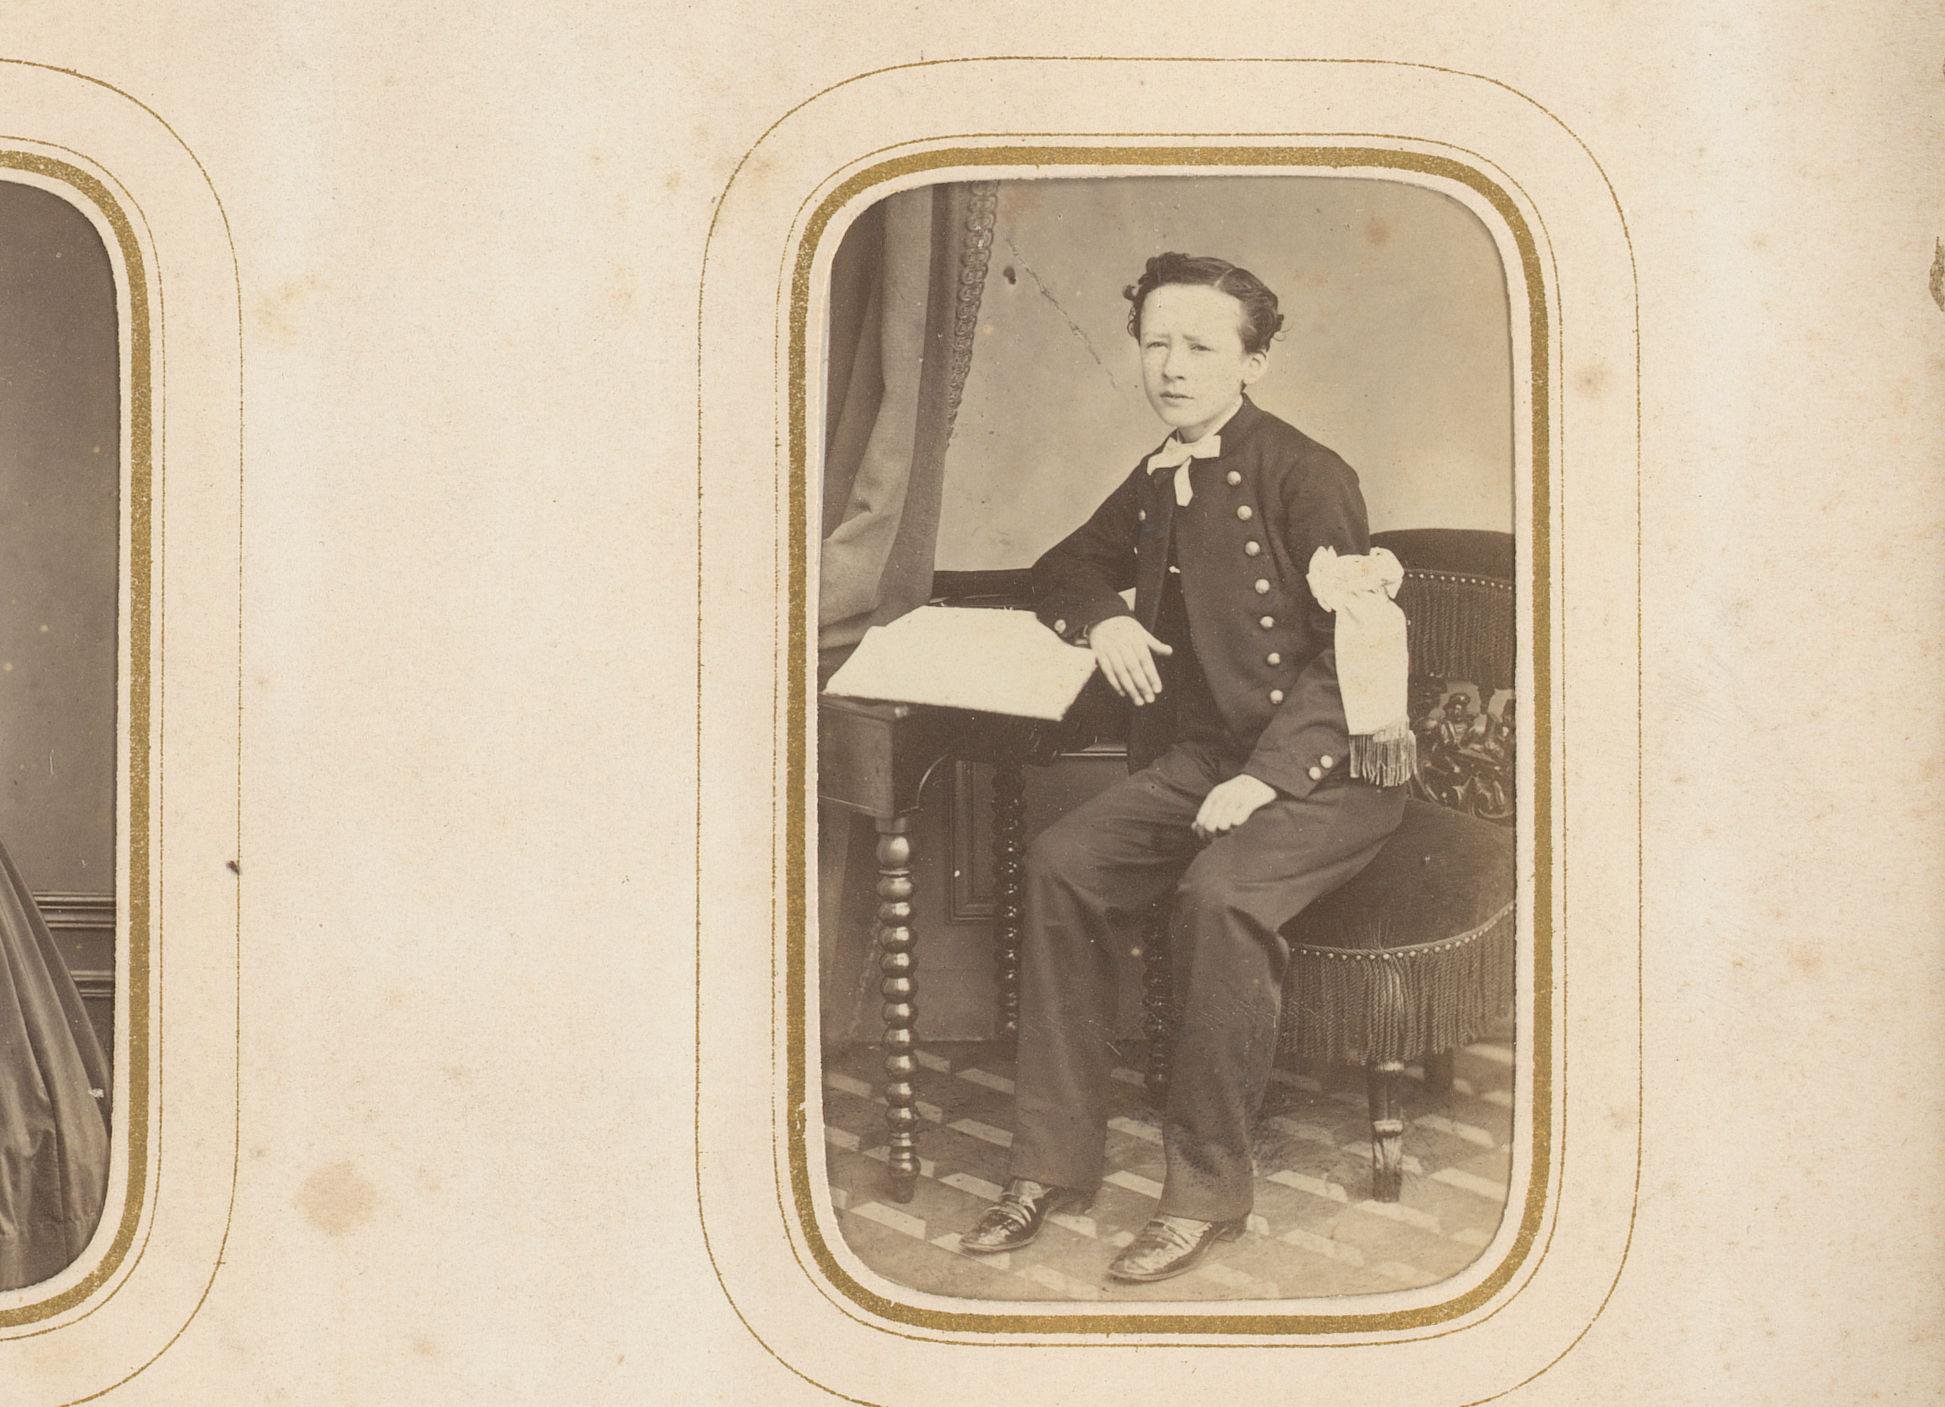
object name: album leaf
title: Portret van een zittende jongen met strik om zijn arm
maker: Anonymous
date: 1860-1890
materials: cardboard, photographic support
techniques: albumen print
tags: boy (child between toddler and youth)